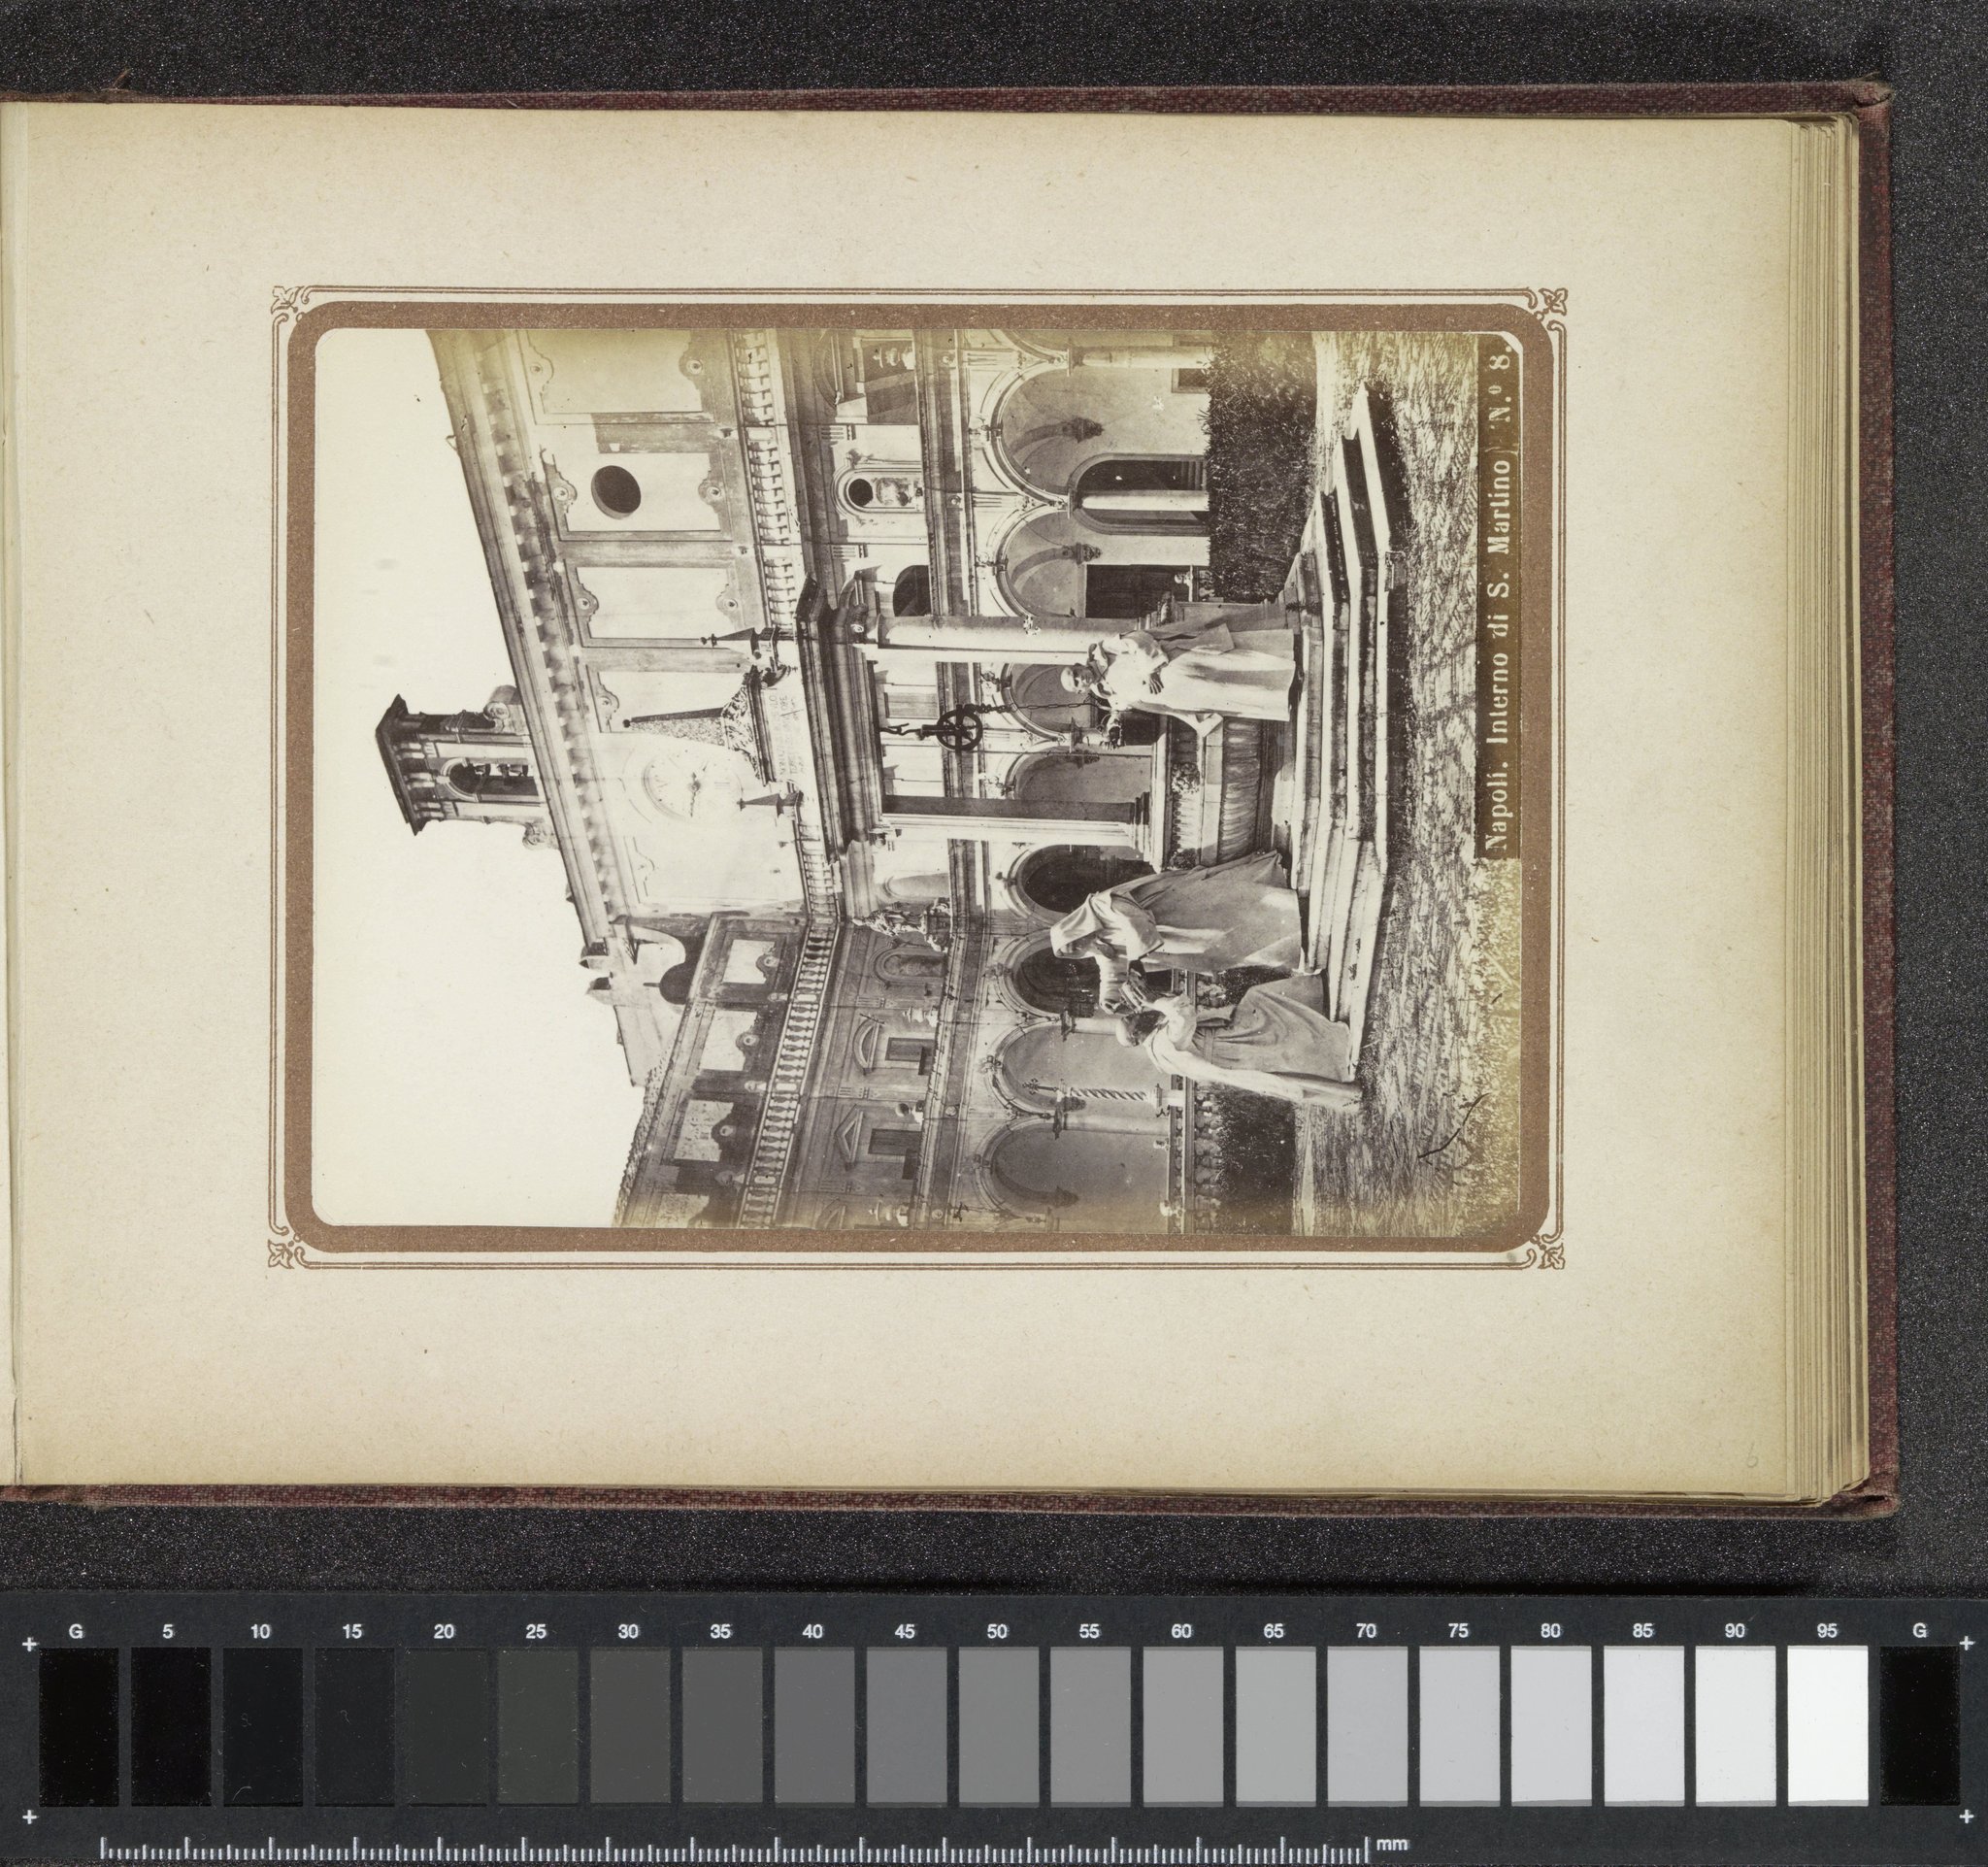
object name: album leaf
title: Binnenplaats van het klooster San Martino in Napels met waterput en monniken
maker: roberto rive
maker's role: fotograaf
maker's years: 1825-1868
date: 1860-1900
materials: paper, photographic support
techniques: albumen print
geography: naples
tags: well, monk(s), friar(s), courtyard, naples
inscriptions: number: ‘8’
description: Onderdeel van Fotoalbum met bezienswaardigheden in Napels en omgeving door Roberto Rive.